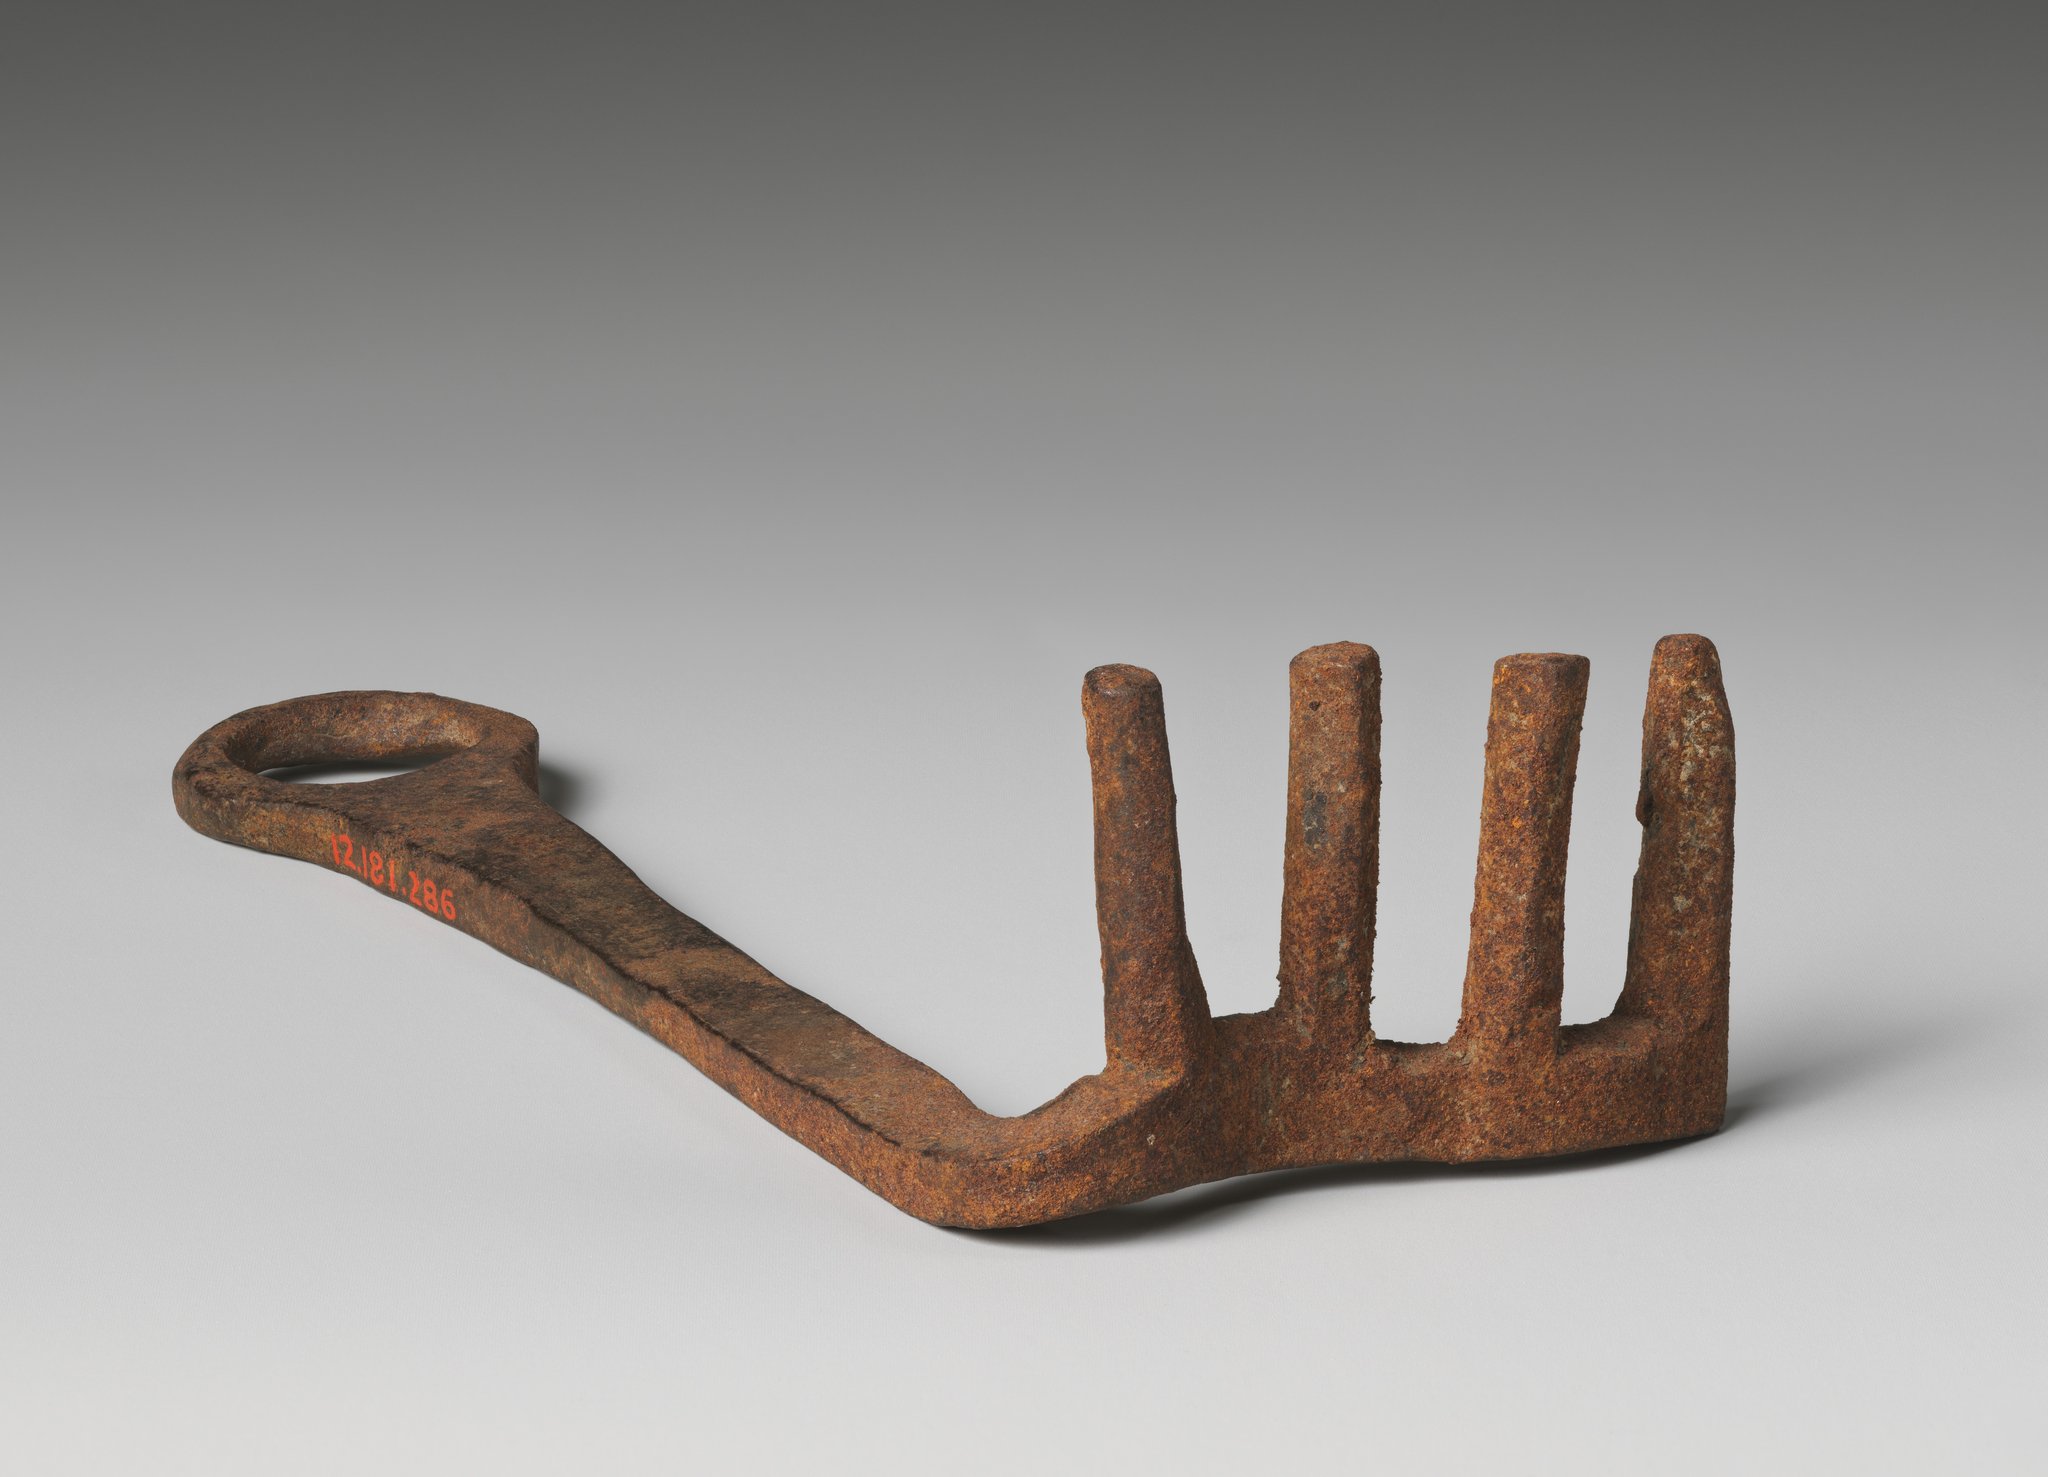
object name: key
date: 306-30 BCE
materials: iron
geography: egypt